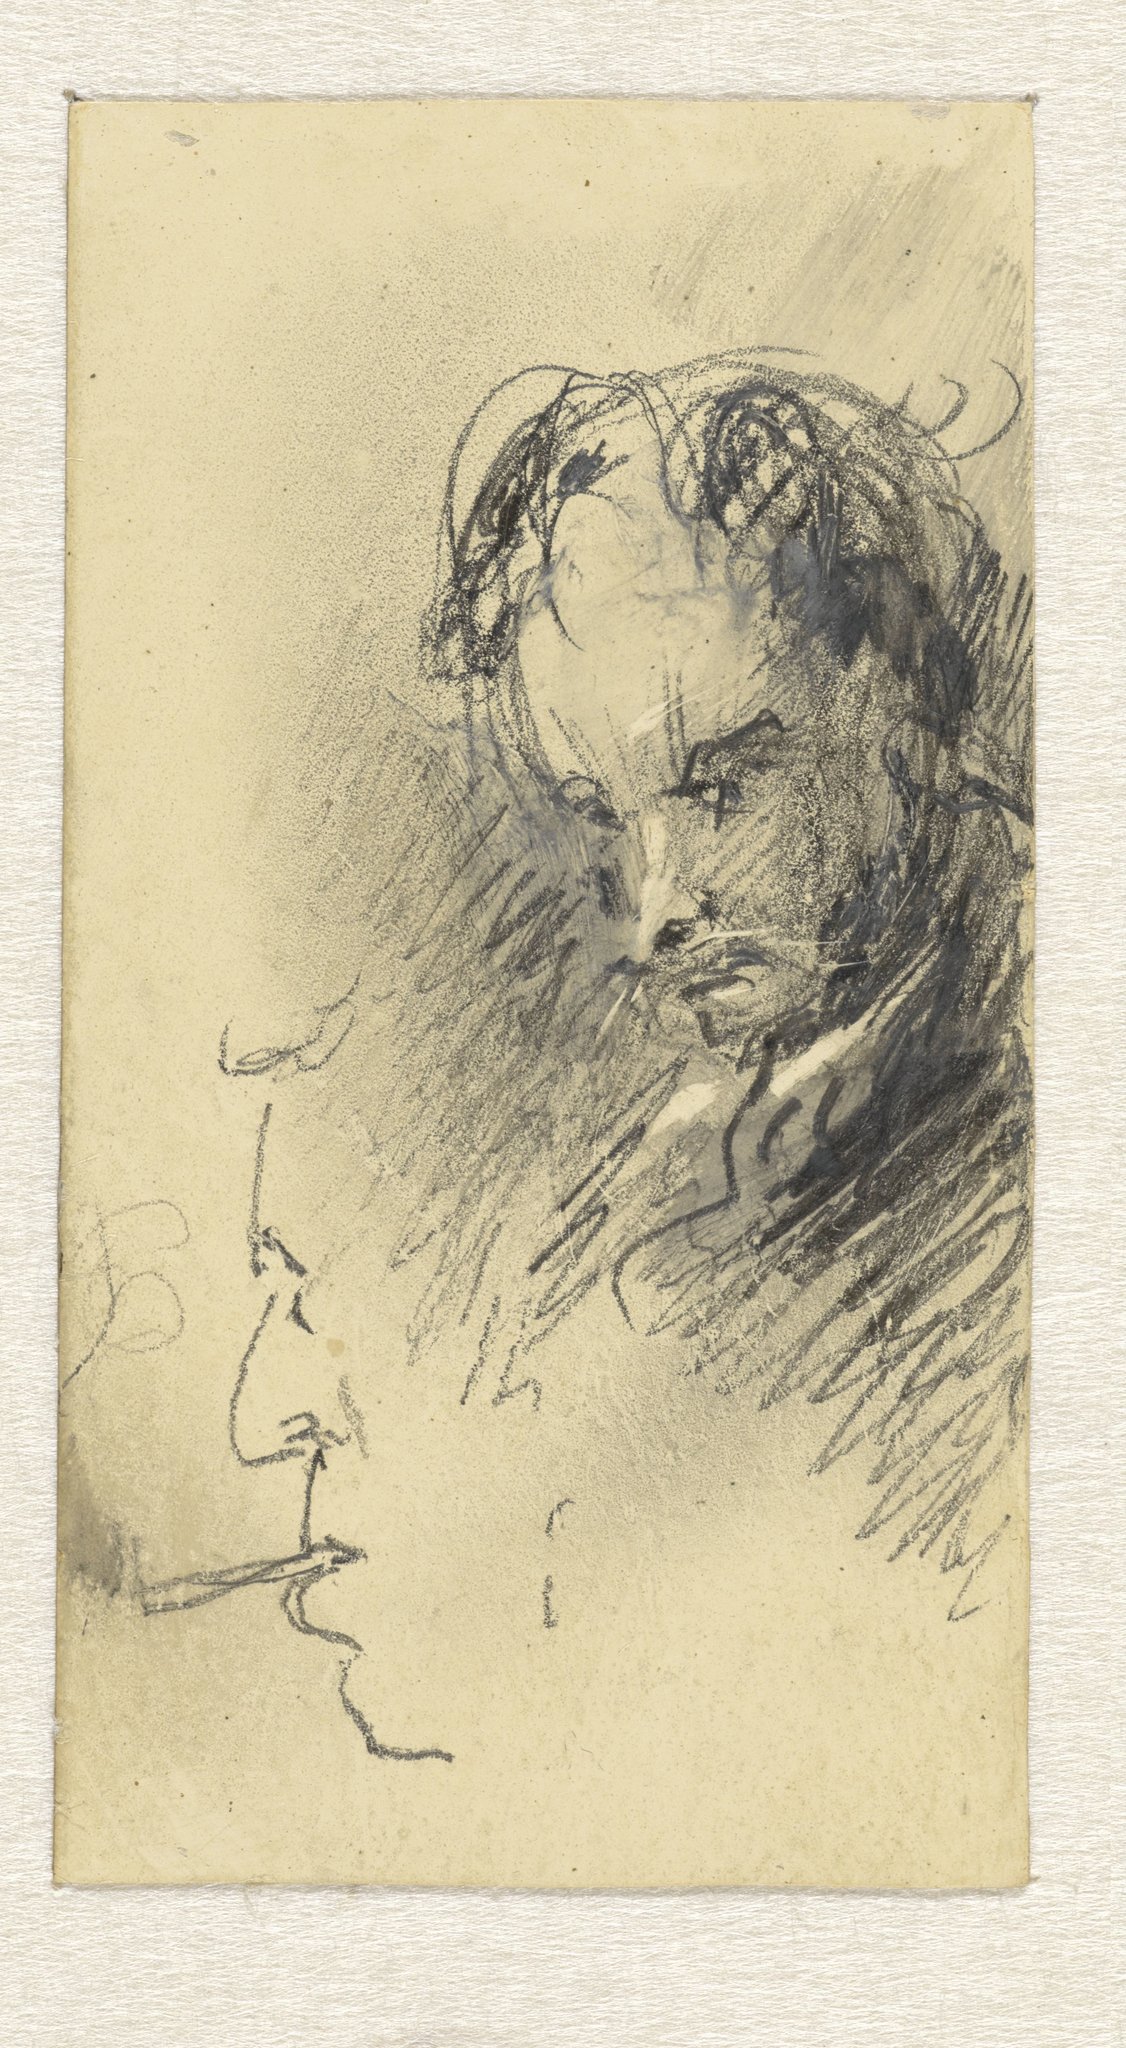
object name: drawing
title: Twee schetsen van mannenhoofden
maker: georgius jacobus johannes van os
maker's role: draughtsman, painter, print maker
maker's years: 1782-1861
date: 1844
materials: paper, pencil